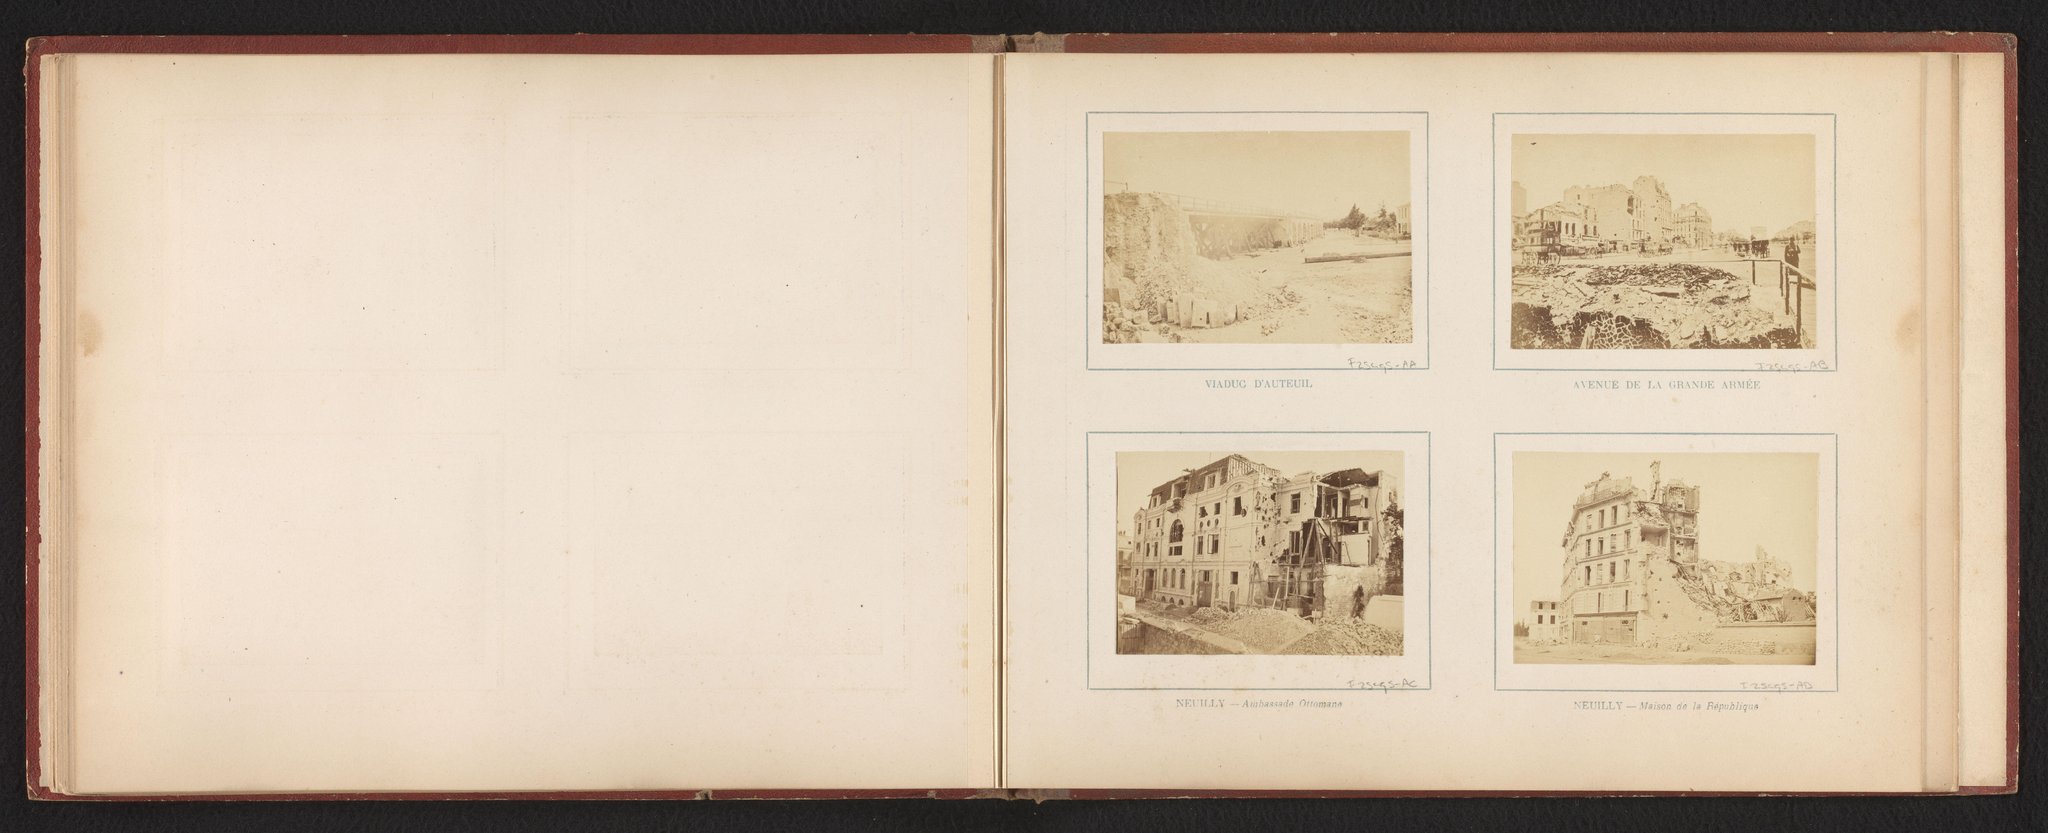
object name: page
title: Gezicht op het verwoeste Viaduc d'Auteuil in Parijs na de semaine sanglante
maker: Anonymous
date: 1871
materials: paper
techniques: albumen print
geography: paris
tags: ruin of a building ~ architecture